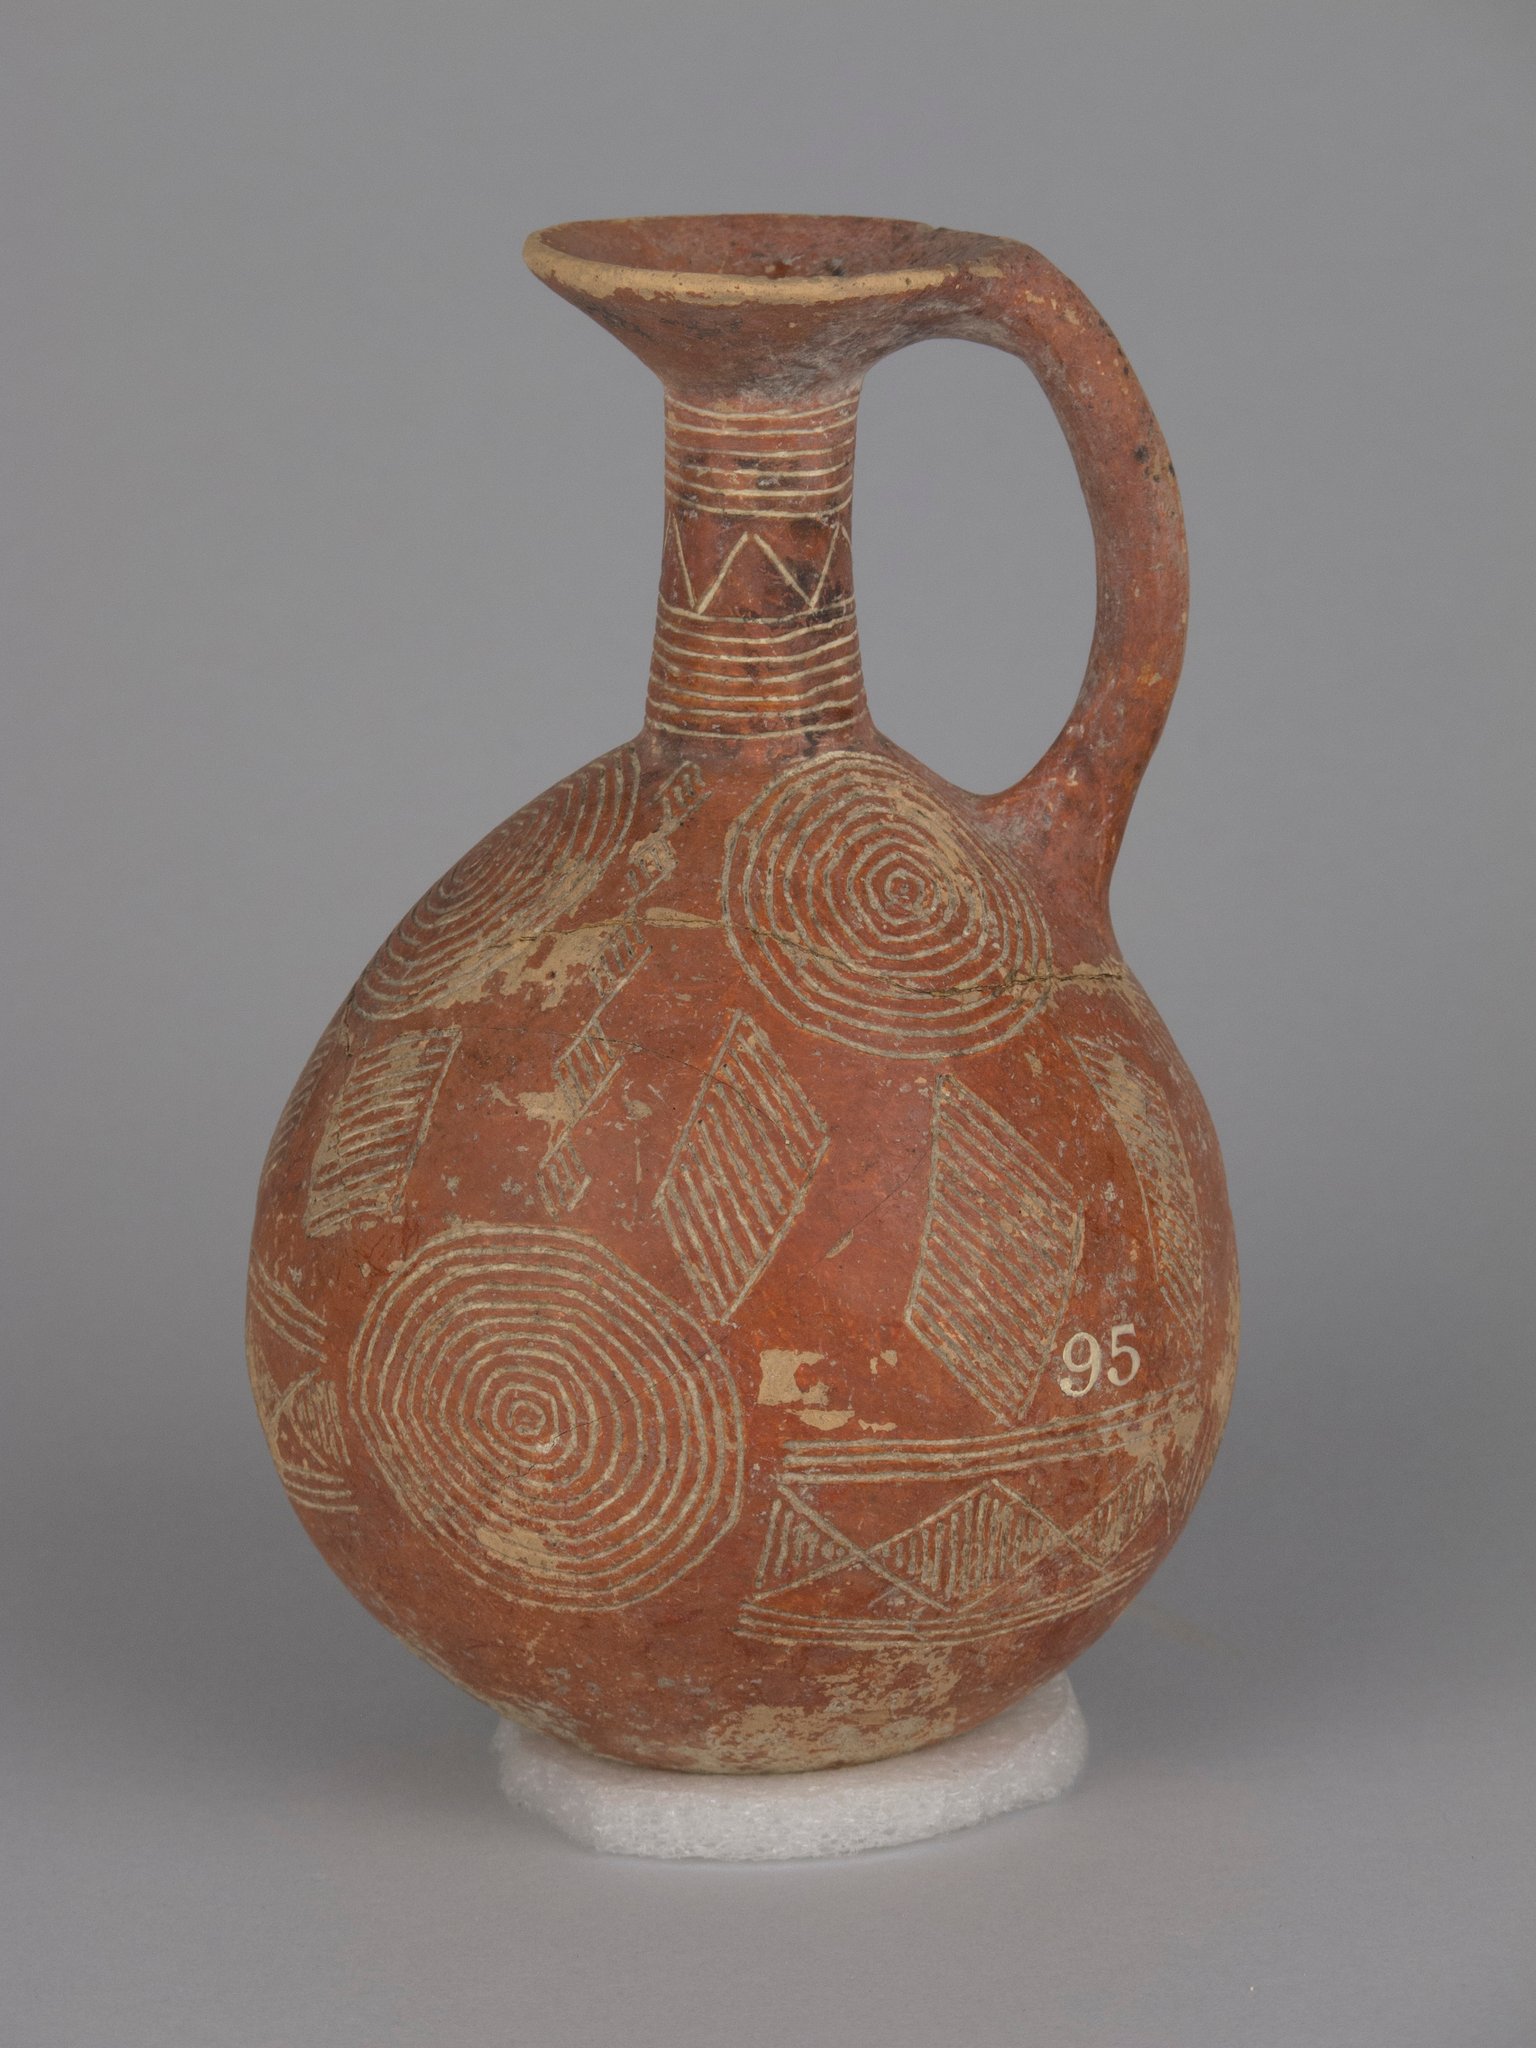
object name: juglet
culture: cypriot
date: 2500-1900 BCE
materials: terracotta